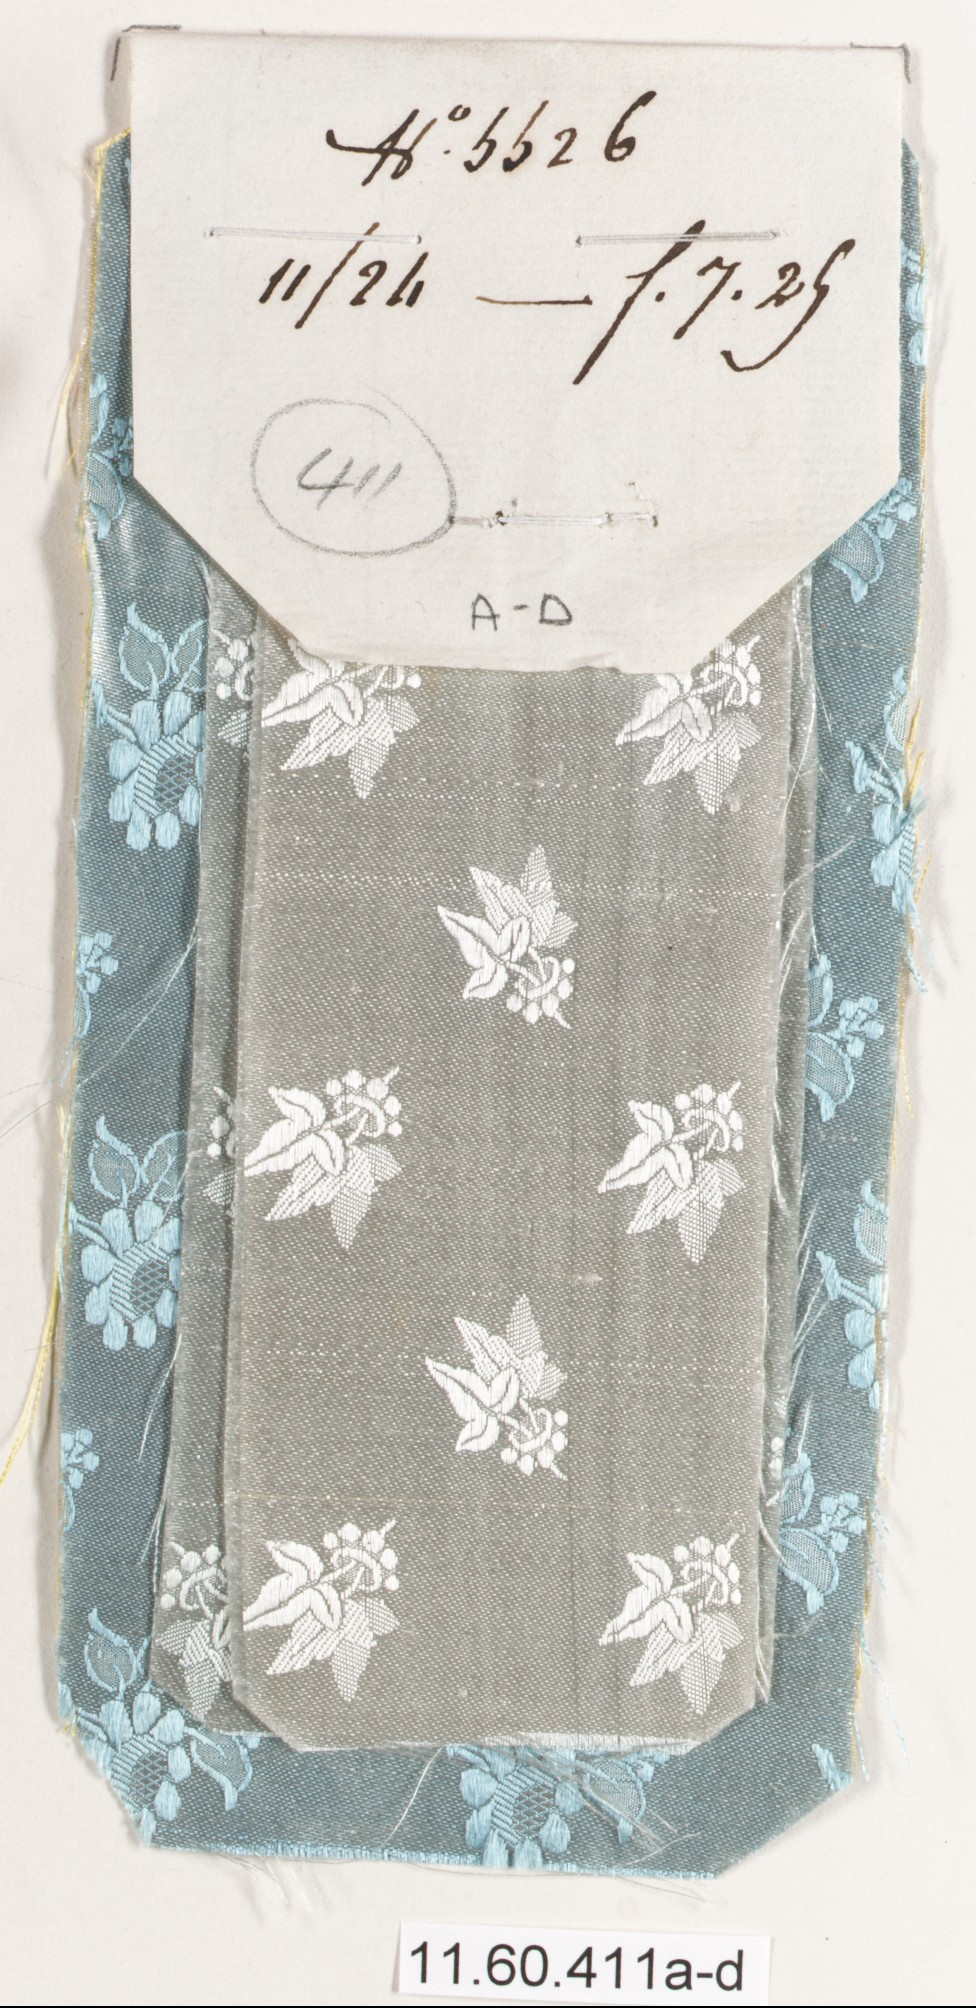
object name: fragment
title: Fragments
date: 1801-1900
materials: silk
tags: flowers